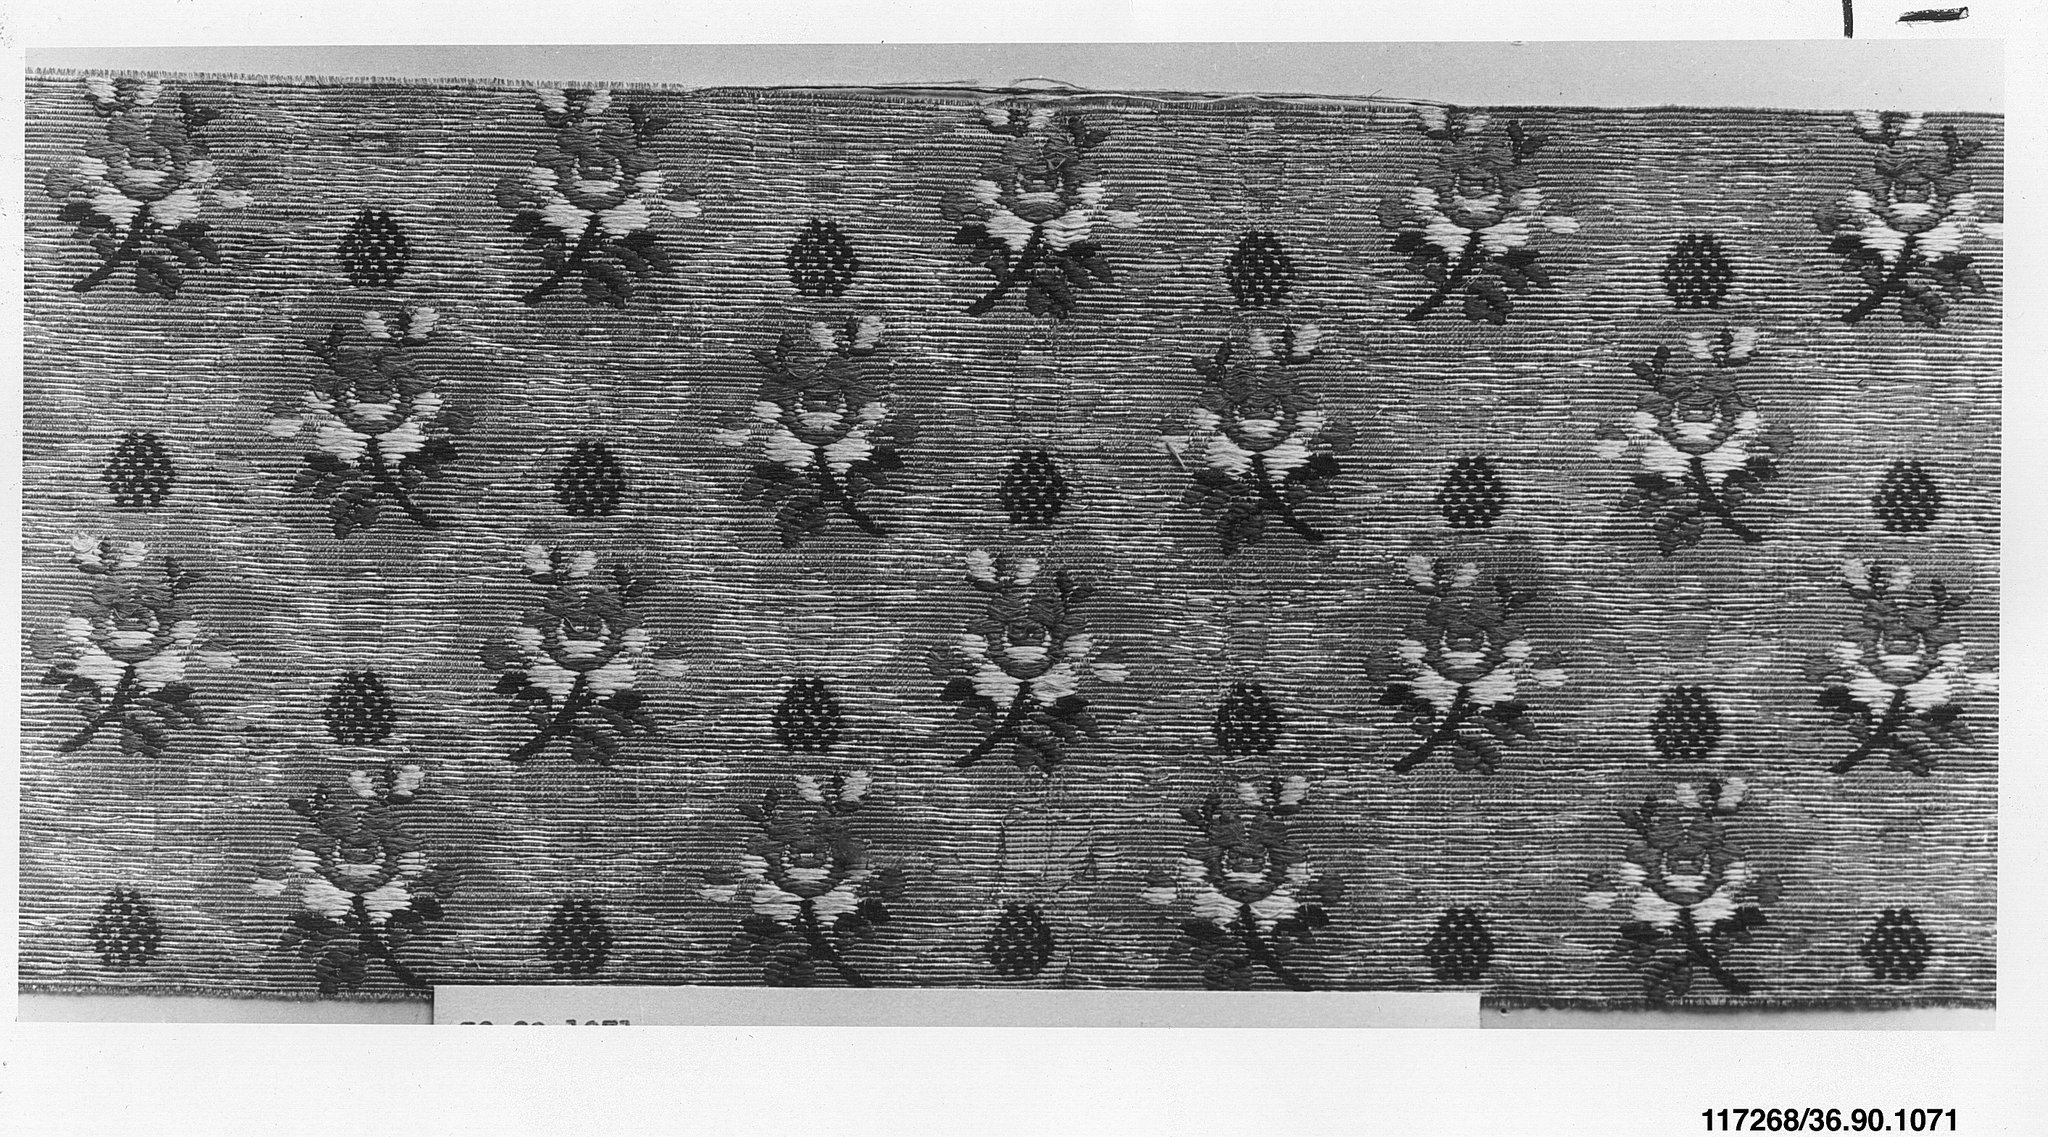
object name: piece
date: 1801-1900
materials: metal thread, silk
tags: flowers